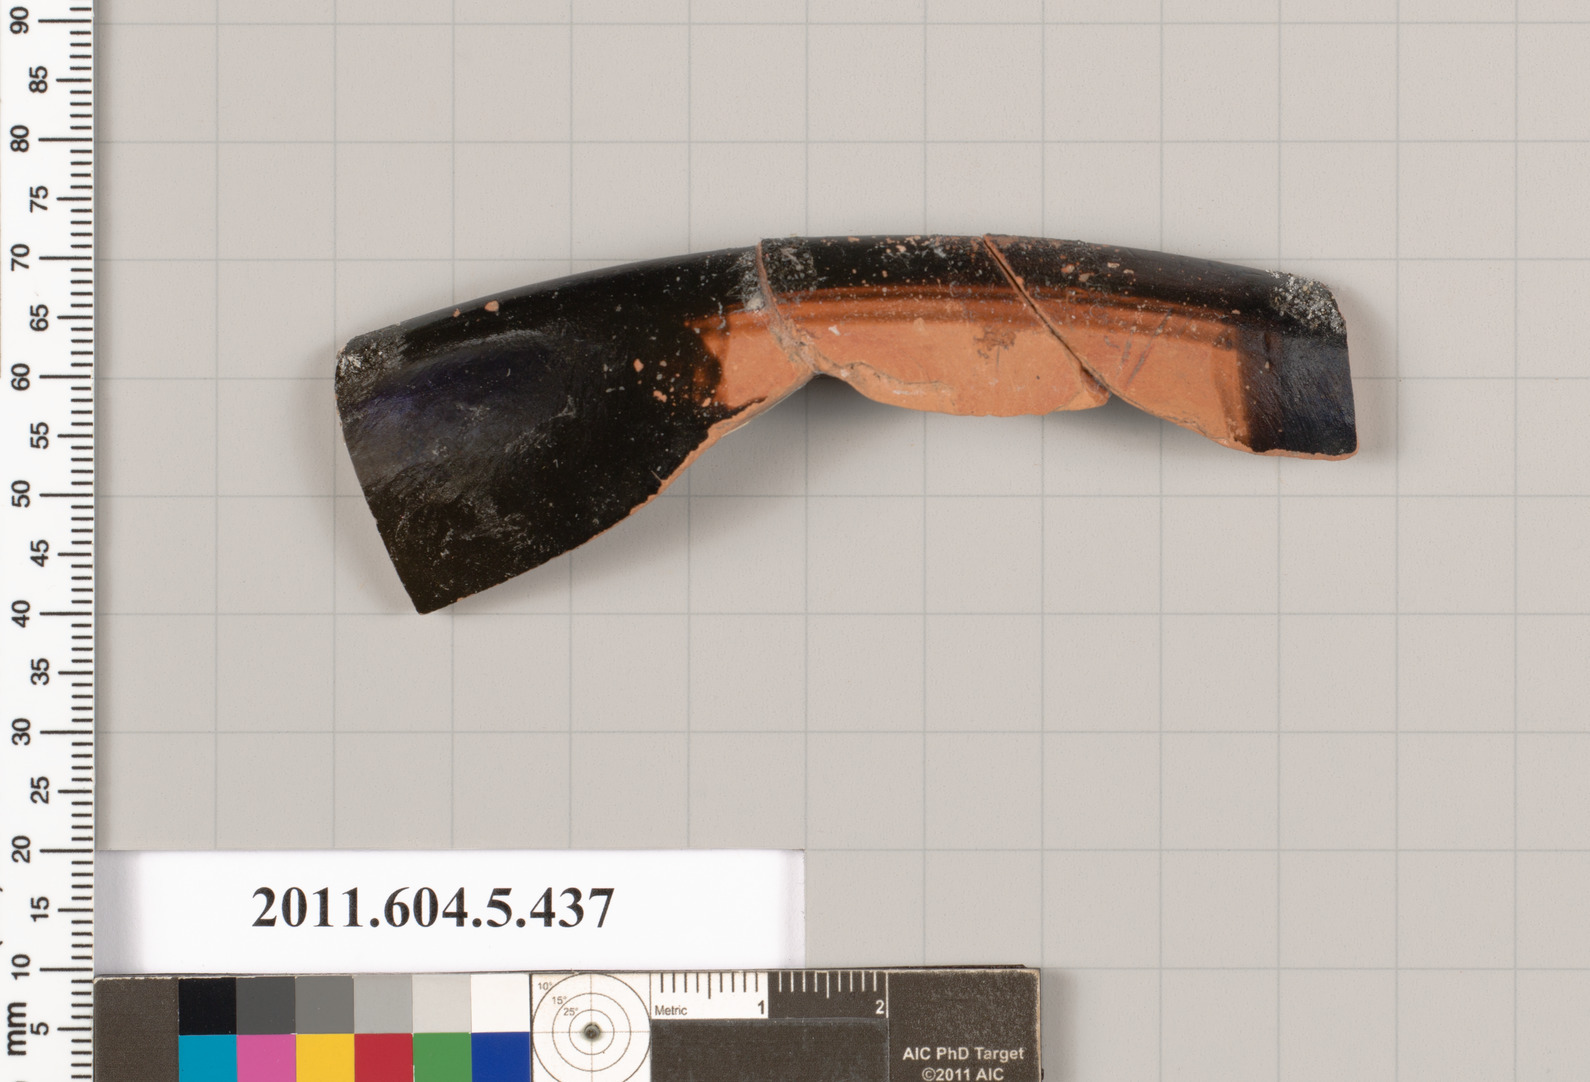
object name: kylix fragment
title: Terracotta rim fragment of a kylix (drinking cup)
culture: greek, attic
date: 600-401 BCE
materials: terracotta